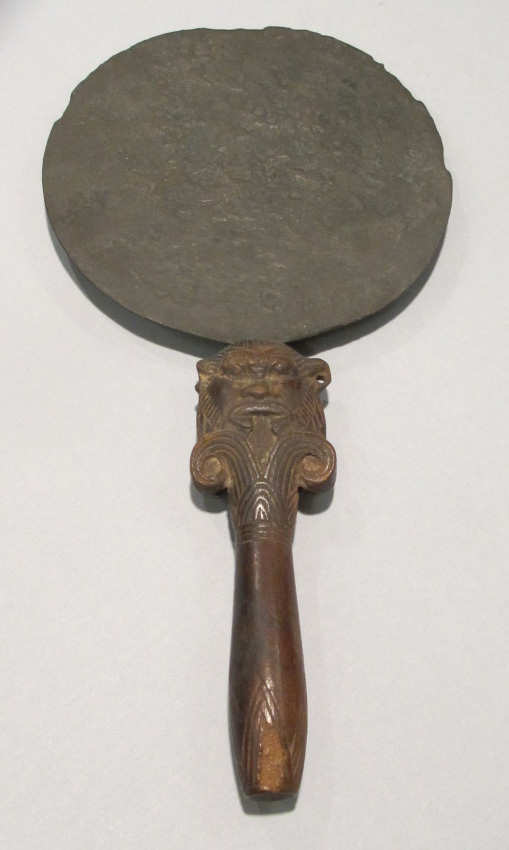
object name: mirror, be, lotus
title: Mirror with a Lotus Handle Decorated with the Head of Bes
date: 1550-1295 BCE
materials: bronze, copper alloy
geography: egypt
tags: bes